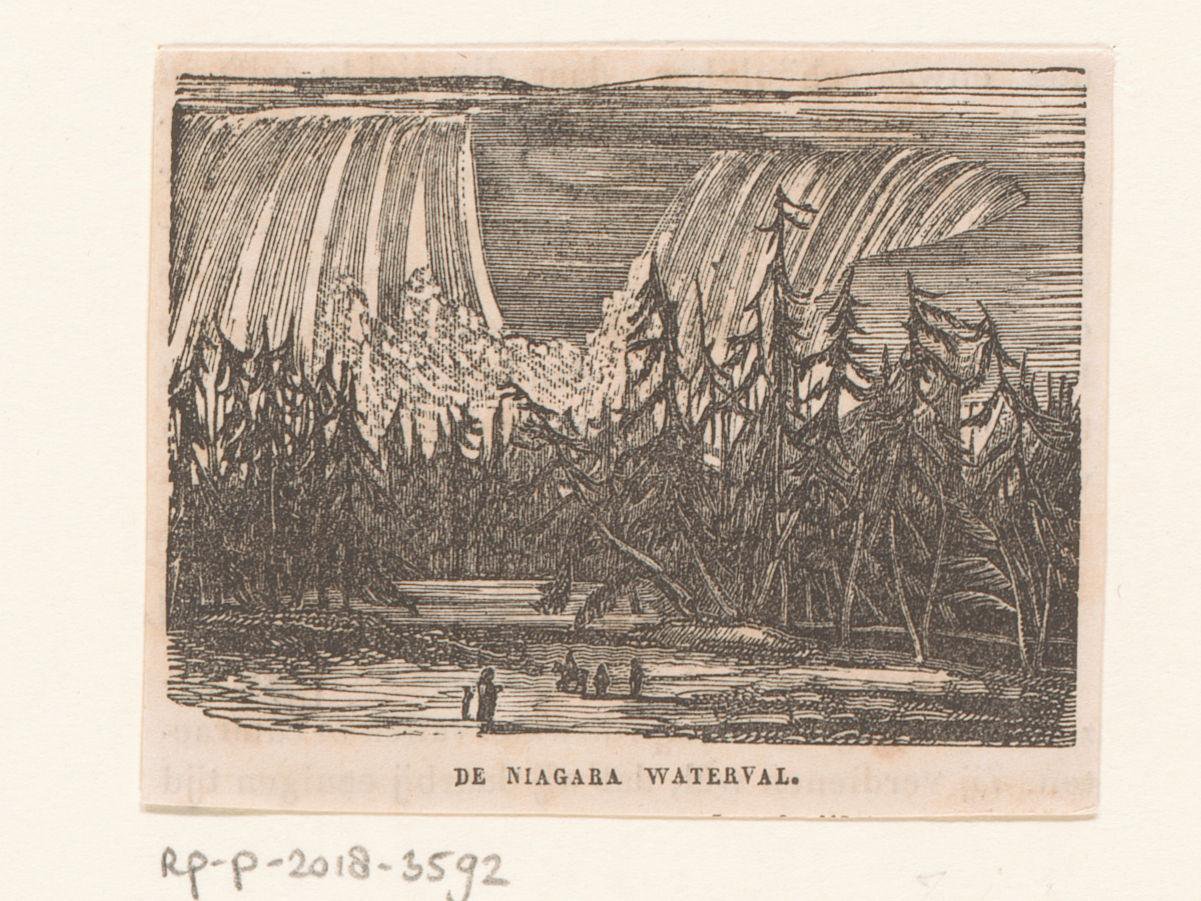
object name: print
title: Niagarawatervallen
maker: Anonymous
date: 1825-1900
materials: paper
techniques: letterpress printing, engraving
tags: waterfall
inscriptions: collector's mark: Lugt 2228